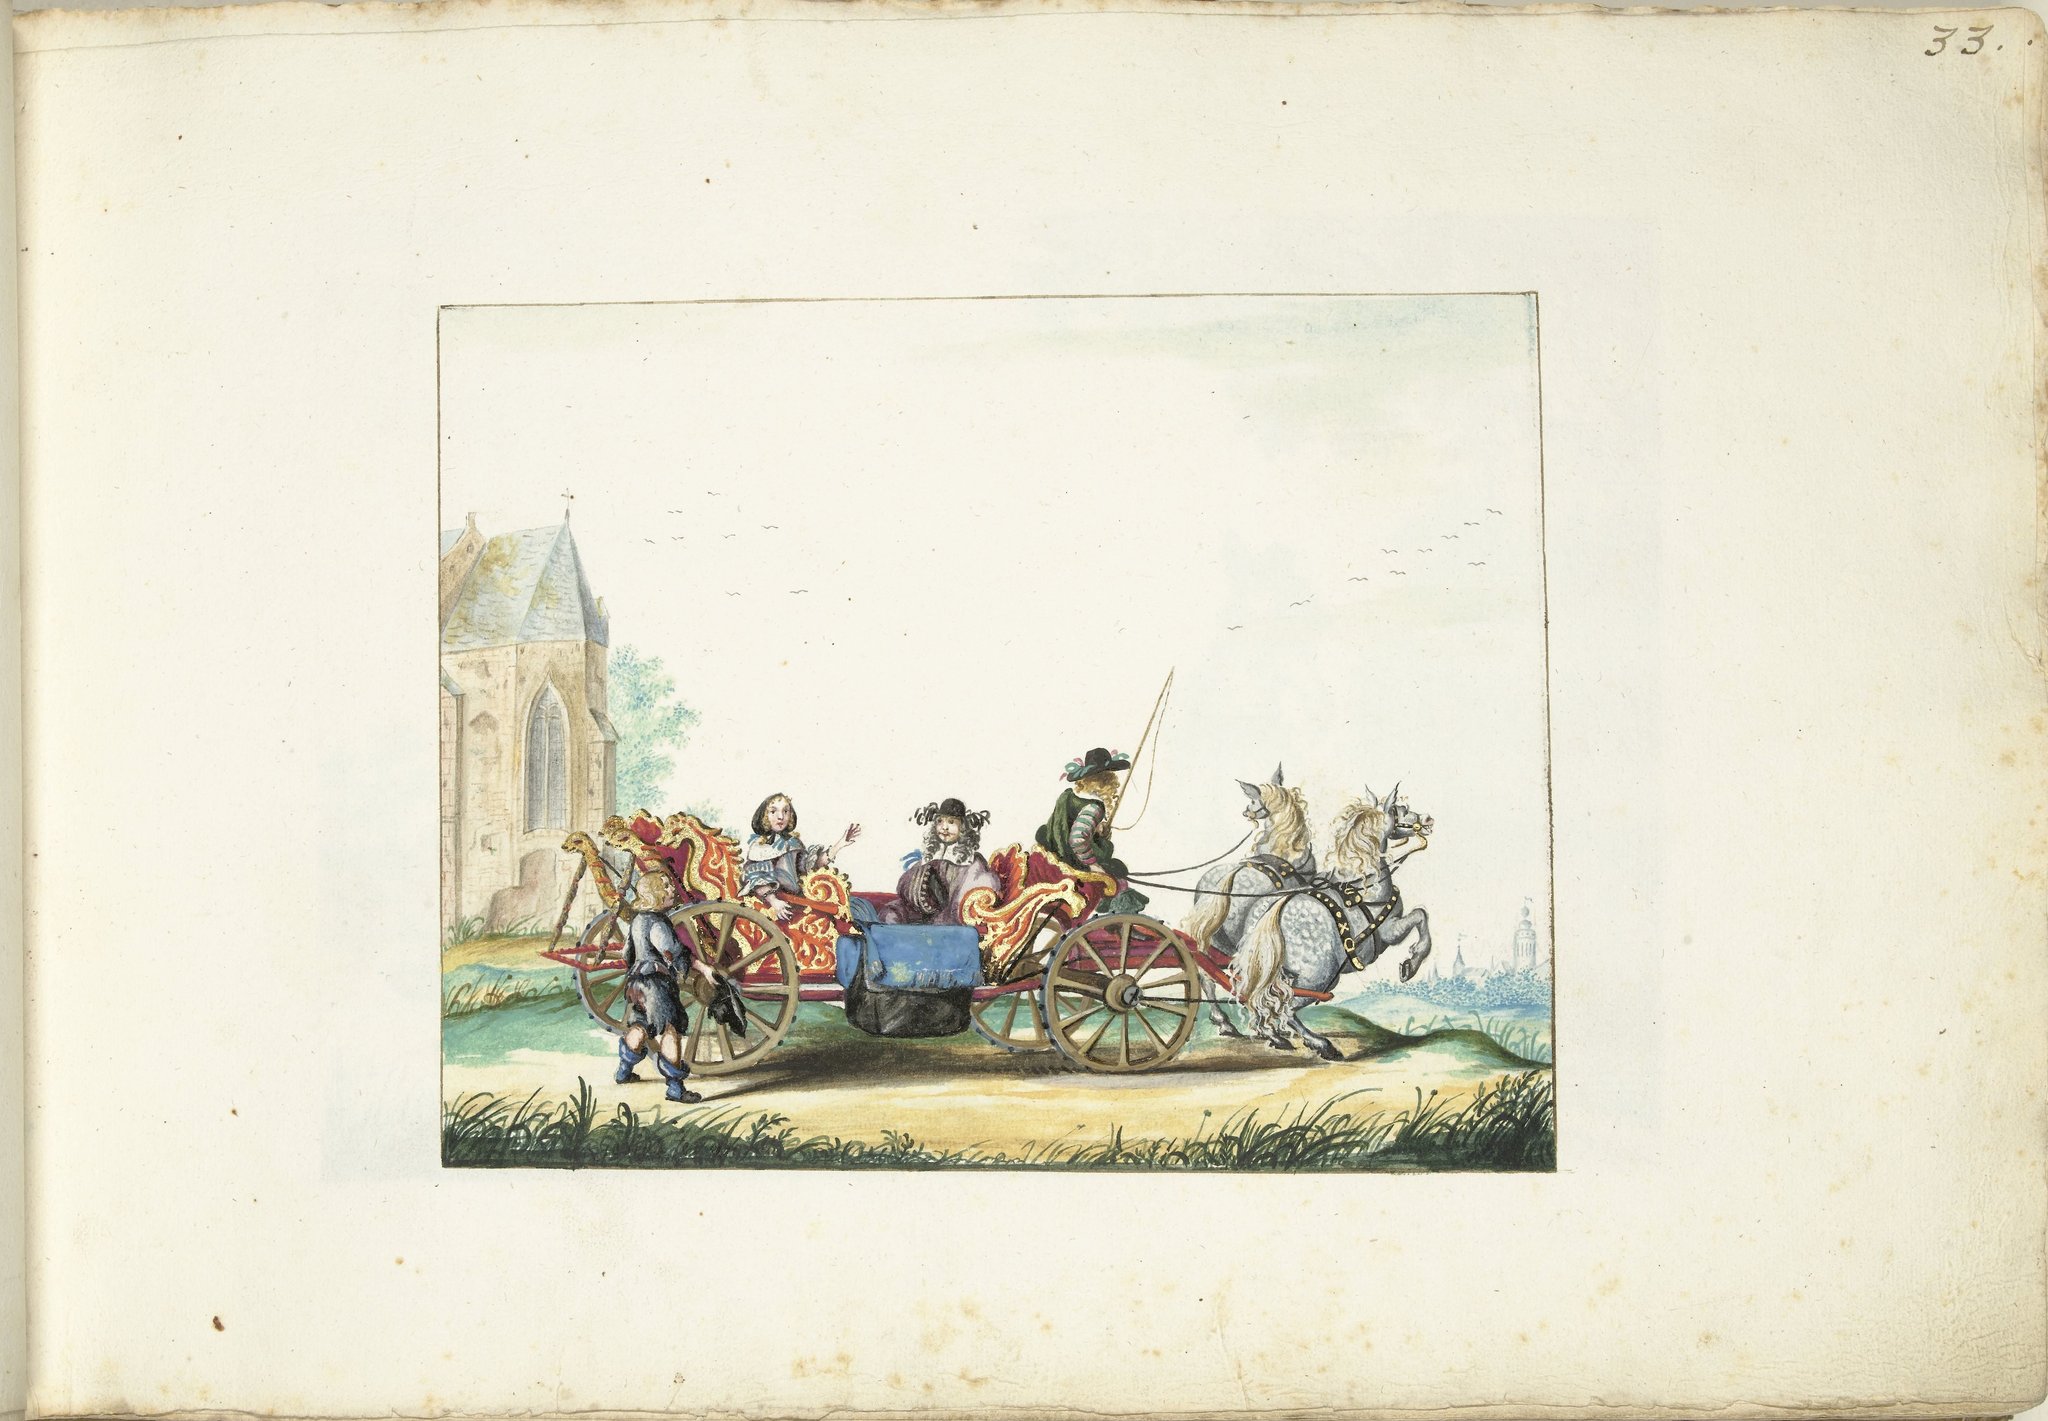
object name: watercolor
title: Jongetje bedelend bij de koets van een elegant paar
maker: gesina ter borch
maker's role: draughtsman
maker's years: 1633-1690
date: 1660-1687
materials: ink, paper, watercolor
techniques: brush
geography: zwolle